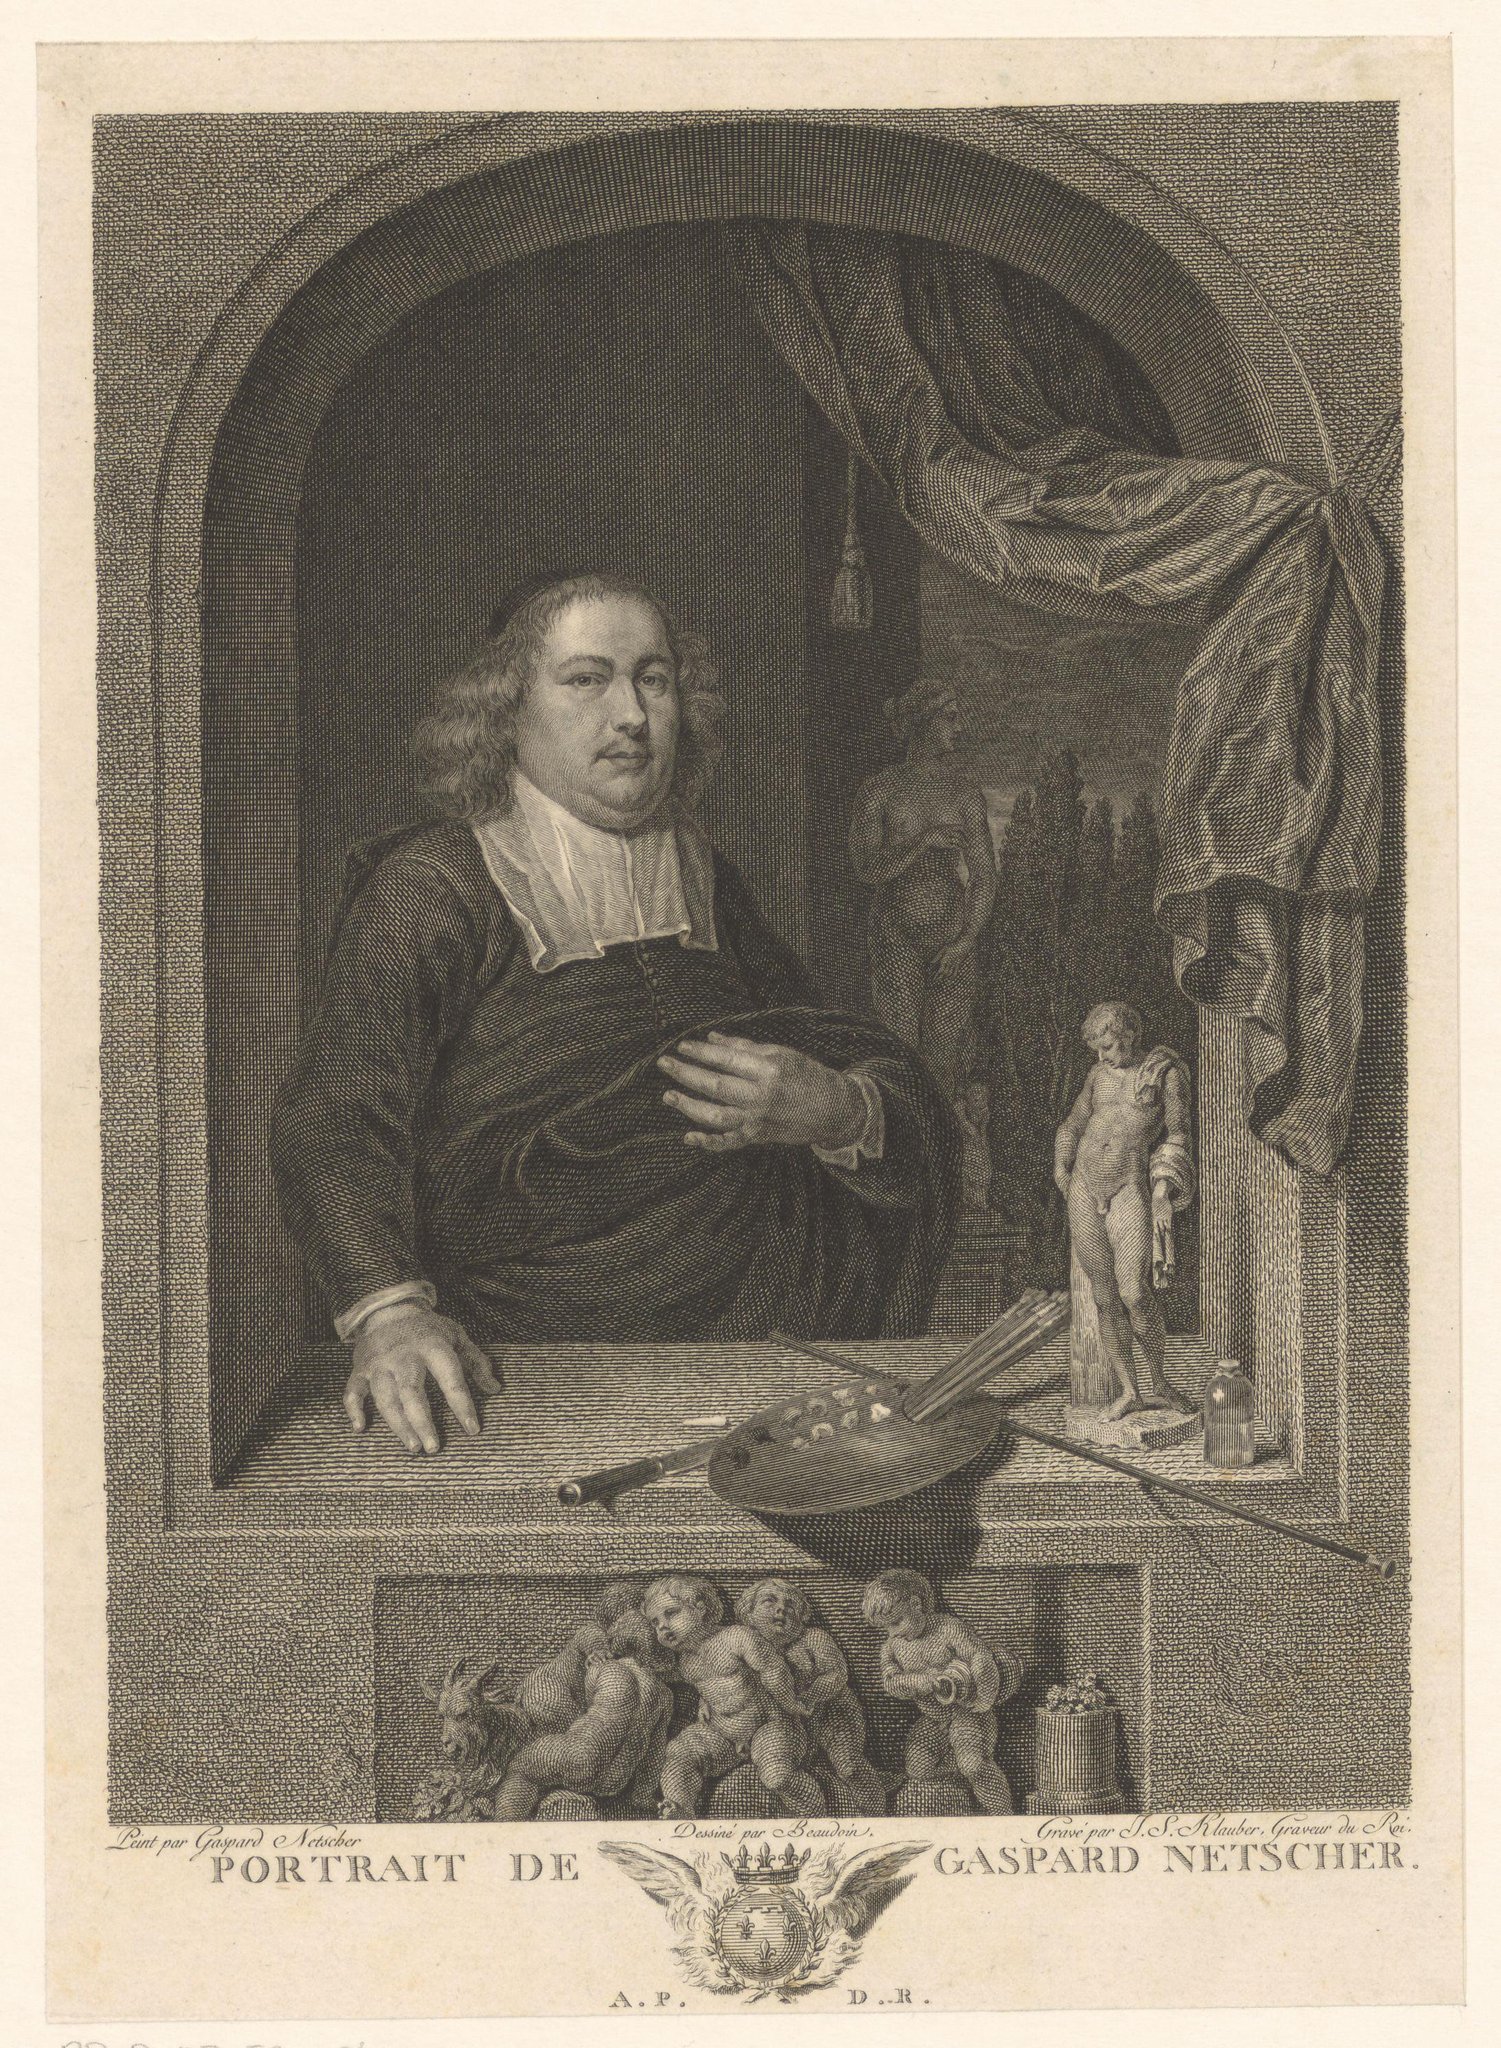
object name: print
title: Portret van Caspar Netscher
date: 1763-1817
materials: paper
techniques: engraving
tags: the hague, painter, draughtsman, caspar netscher, historical persons, portrait, self-portrait of painter, monument, statue, painting (including book-illumination, miniature-painting)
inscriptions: collector's mark: Lugt 2228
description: Onder het wapen staan de letters A.P.D.R. welke staan voor "Avec Privilege du Roi'.